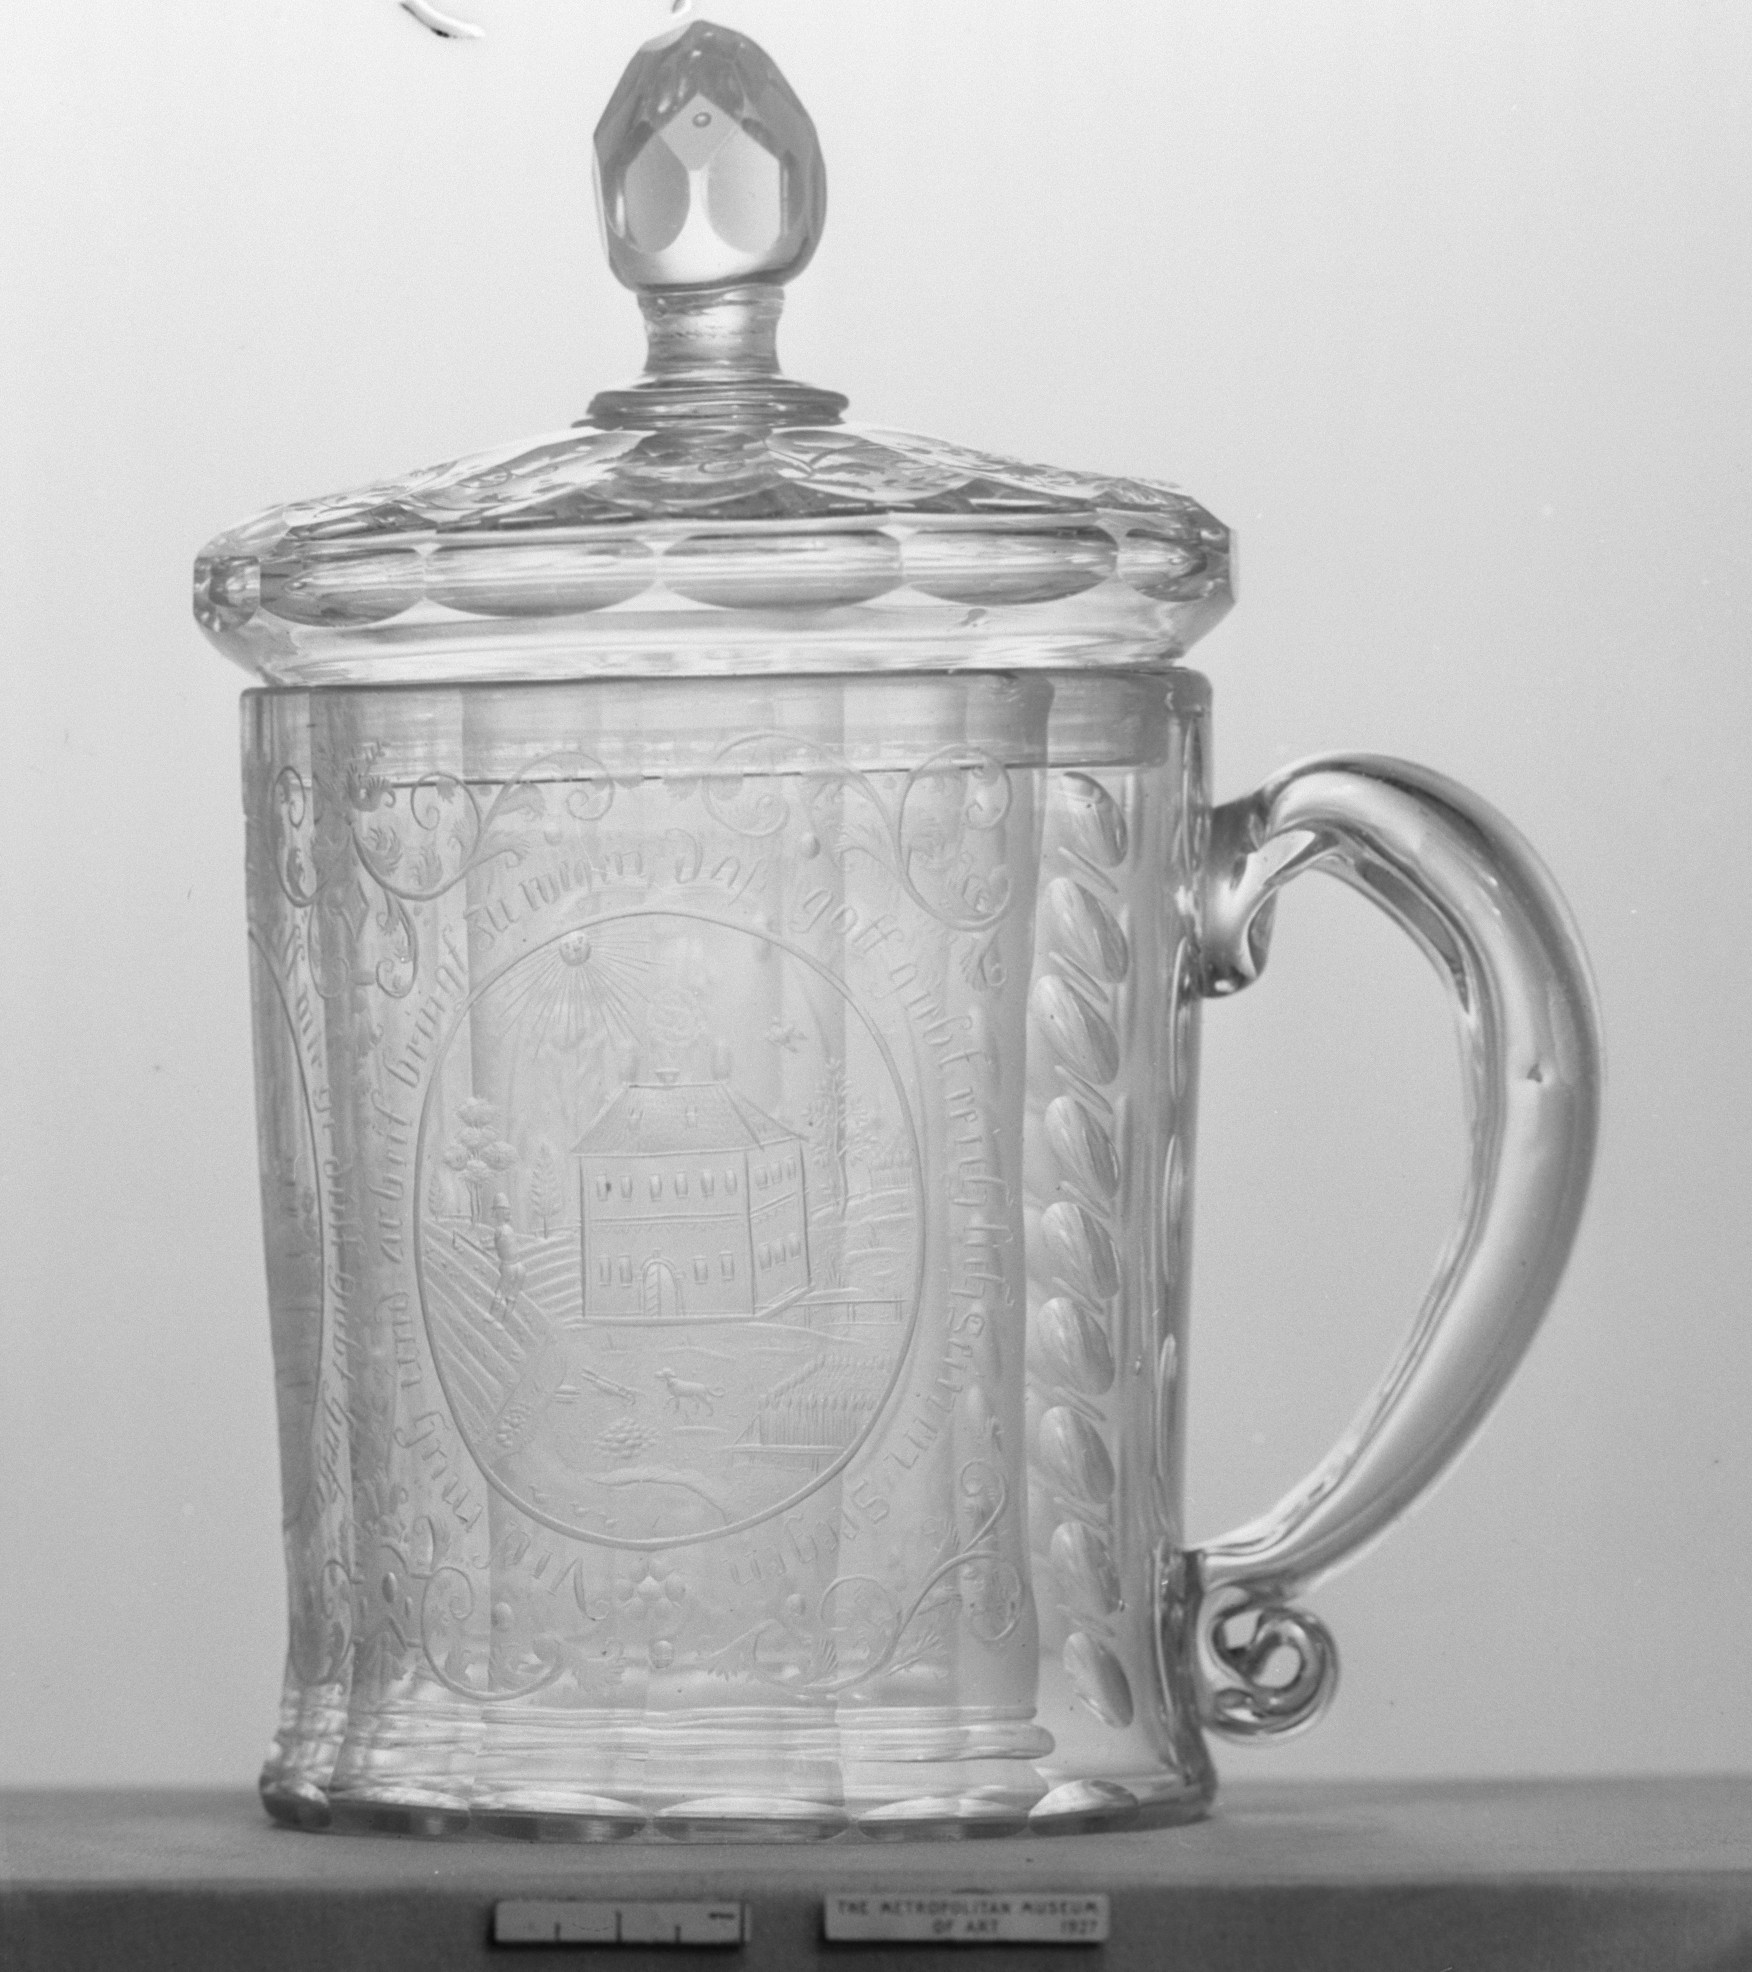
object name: mug with cover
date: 1730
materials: glass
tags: houses